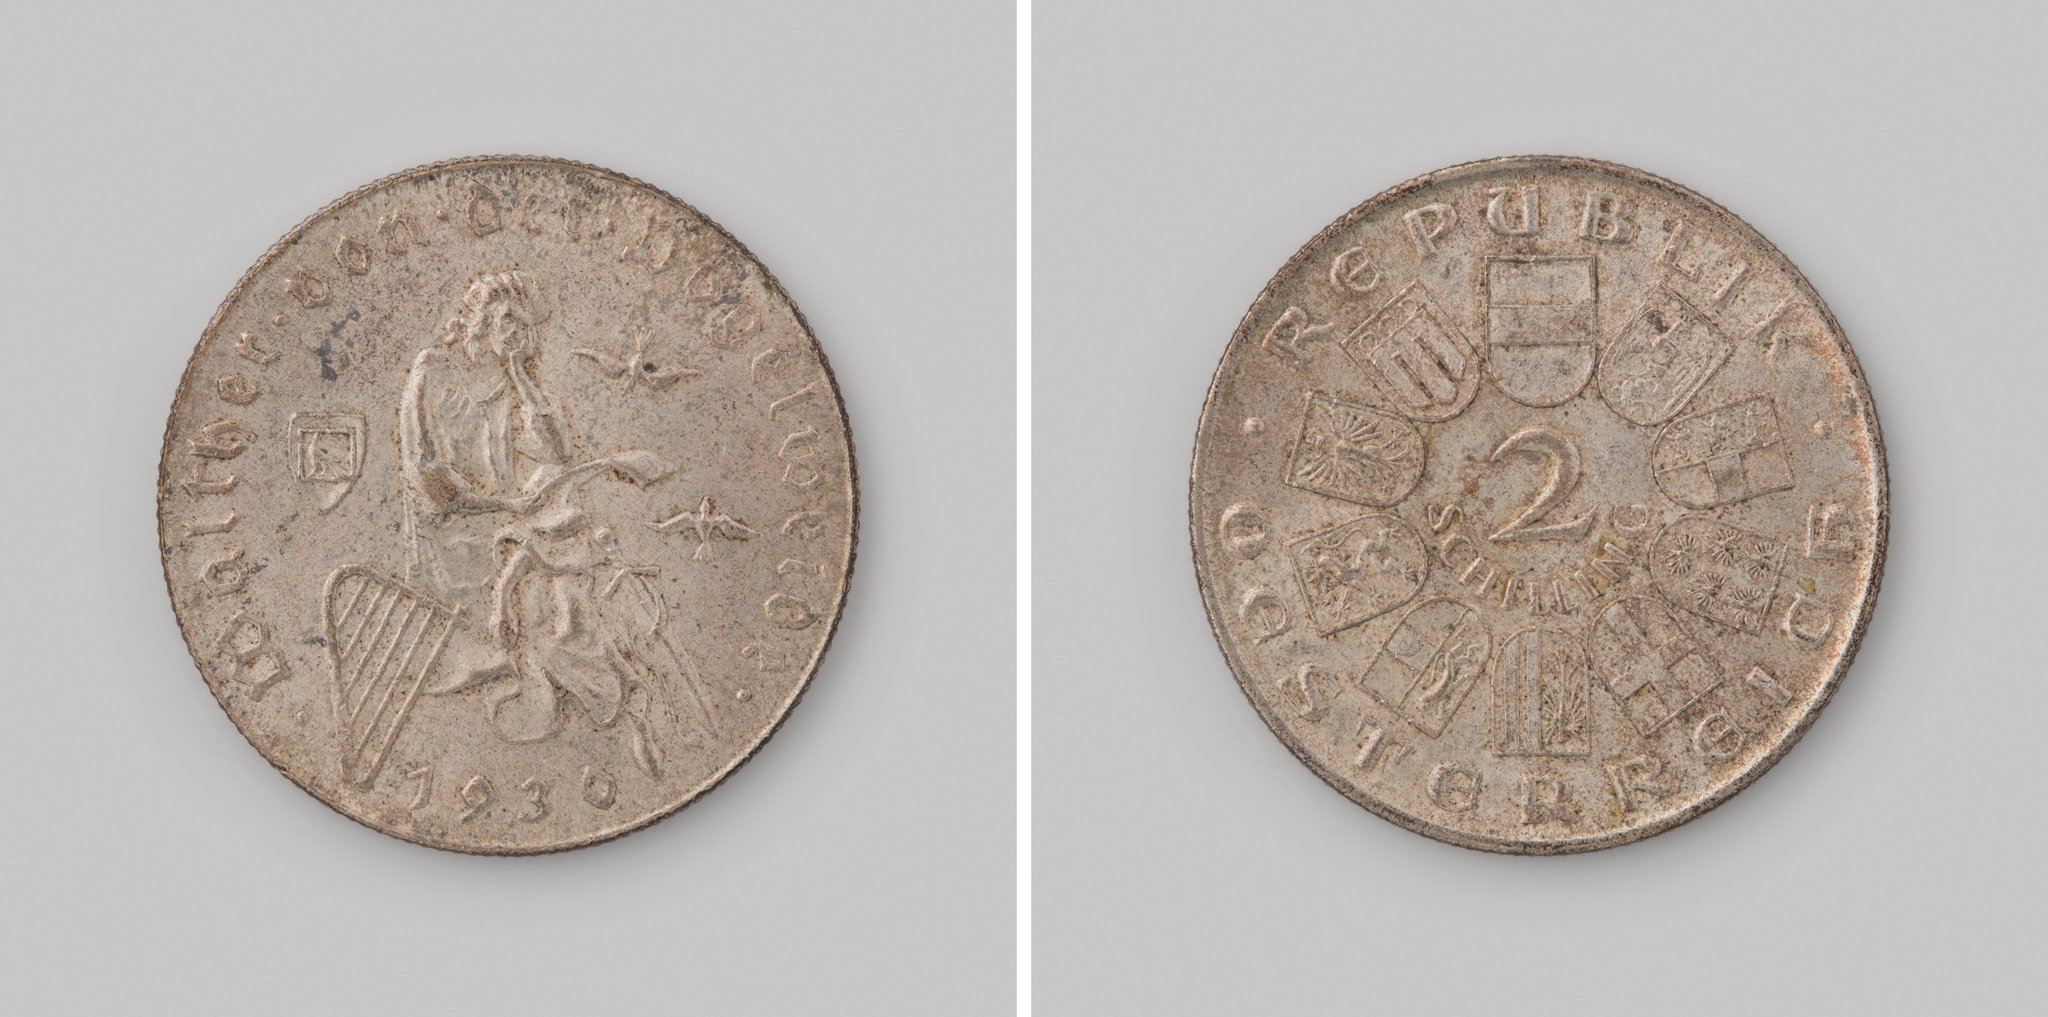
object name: coin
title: 2 schillling uit de republiek Oostenrijk,1930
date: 1930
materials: silver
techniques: striking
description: Zilveren munt ter gelegenheid van het overlijden van Walther von der Vogelweide 700 jaar geleden. Voorzijde: Walther, zittend naar rechts, nasst hem een lier, rechts twee vogels en links wapenschild. jaartal onderaan. Keerzijde: binnen een ring van tien wapenschilden waarde-aanduiding. Kartelrand.